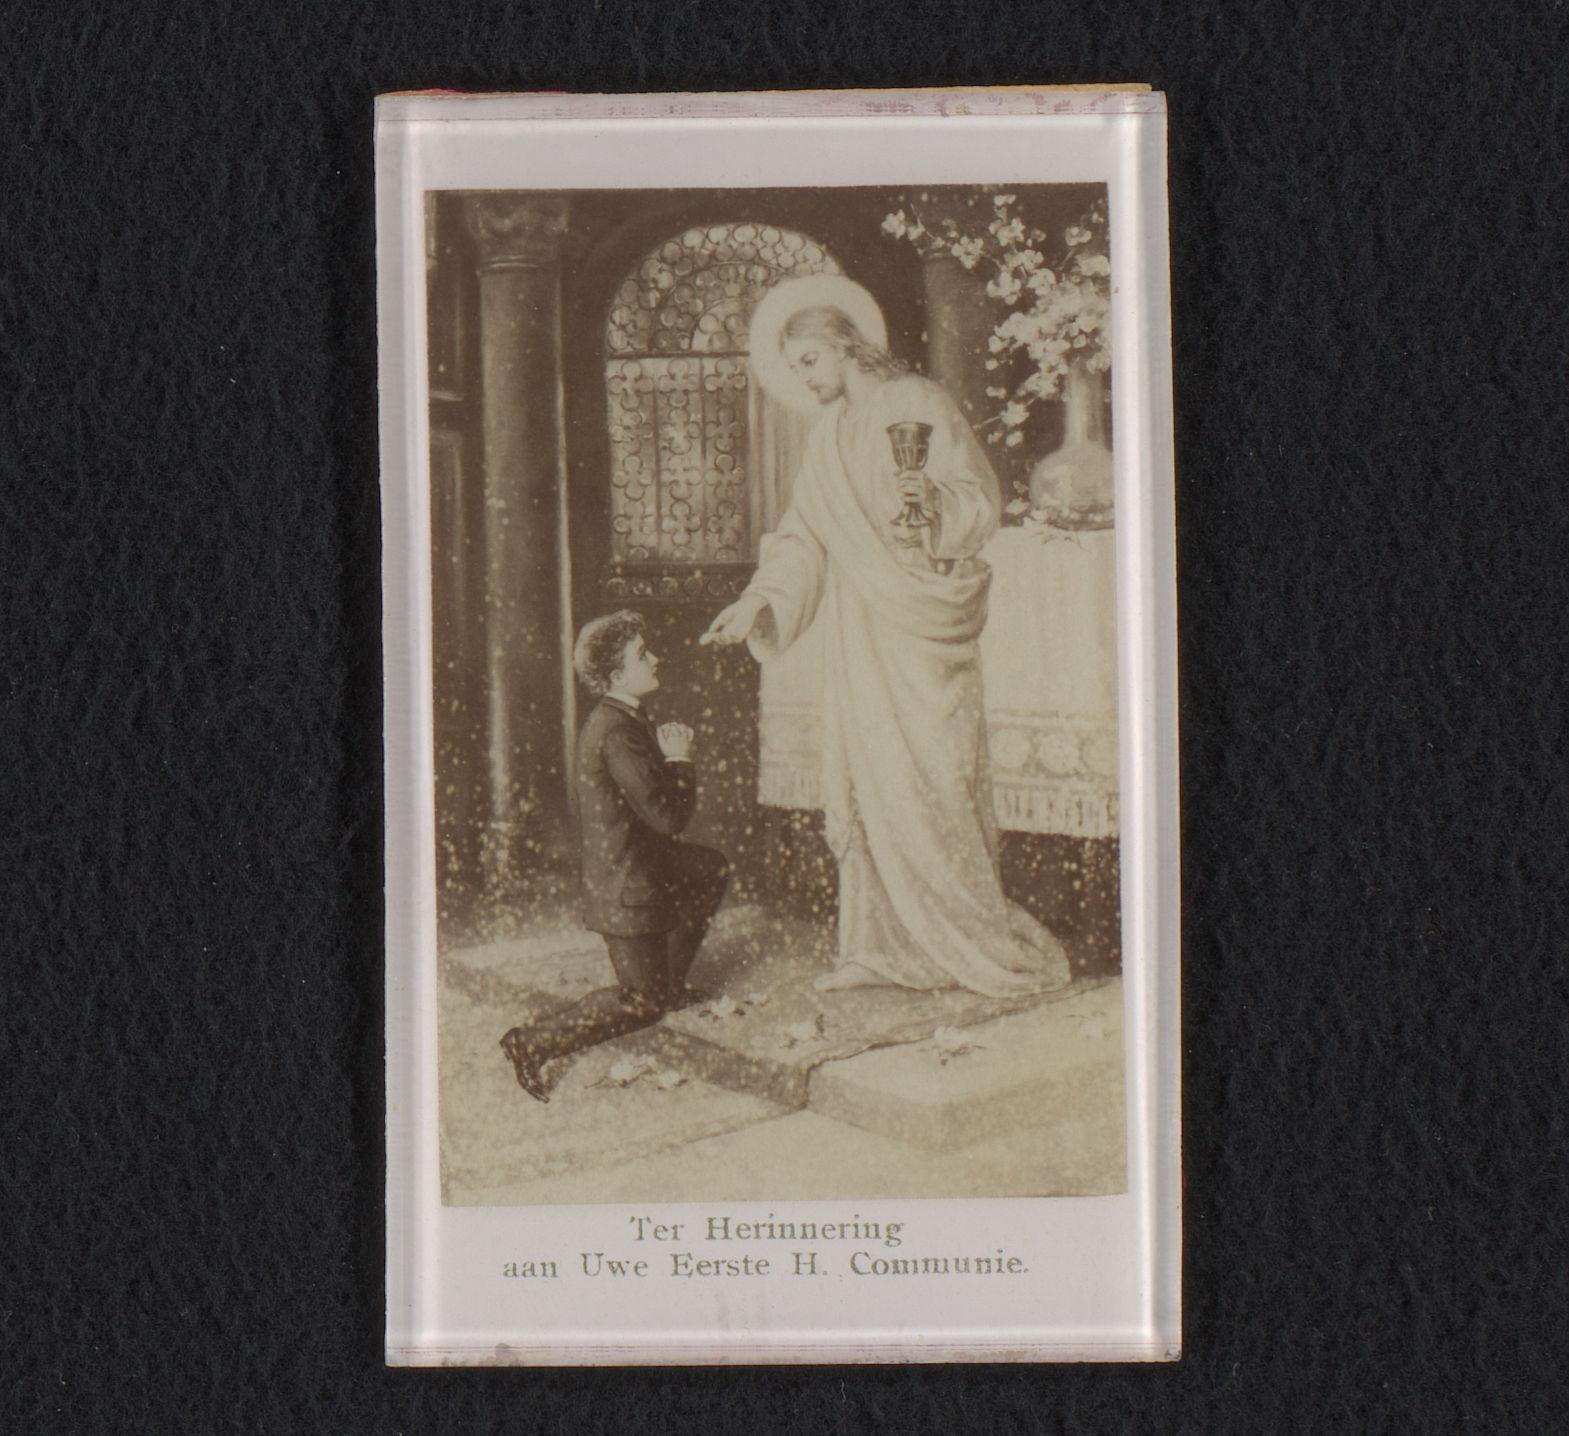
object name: photograph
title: Fotoreproductie van een schilderij, communicant knielt voor Christus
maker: Anonymous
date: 1851-1900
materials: cardboard, glass, paper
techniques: albumen print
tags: first communion